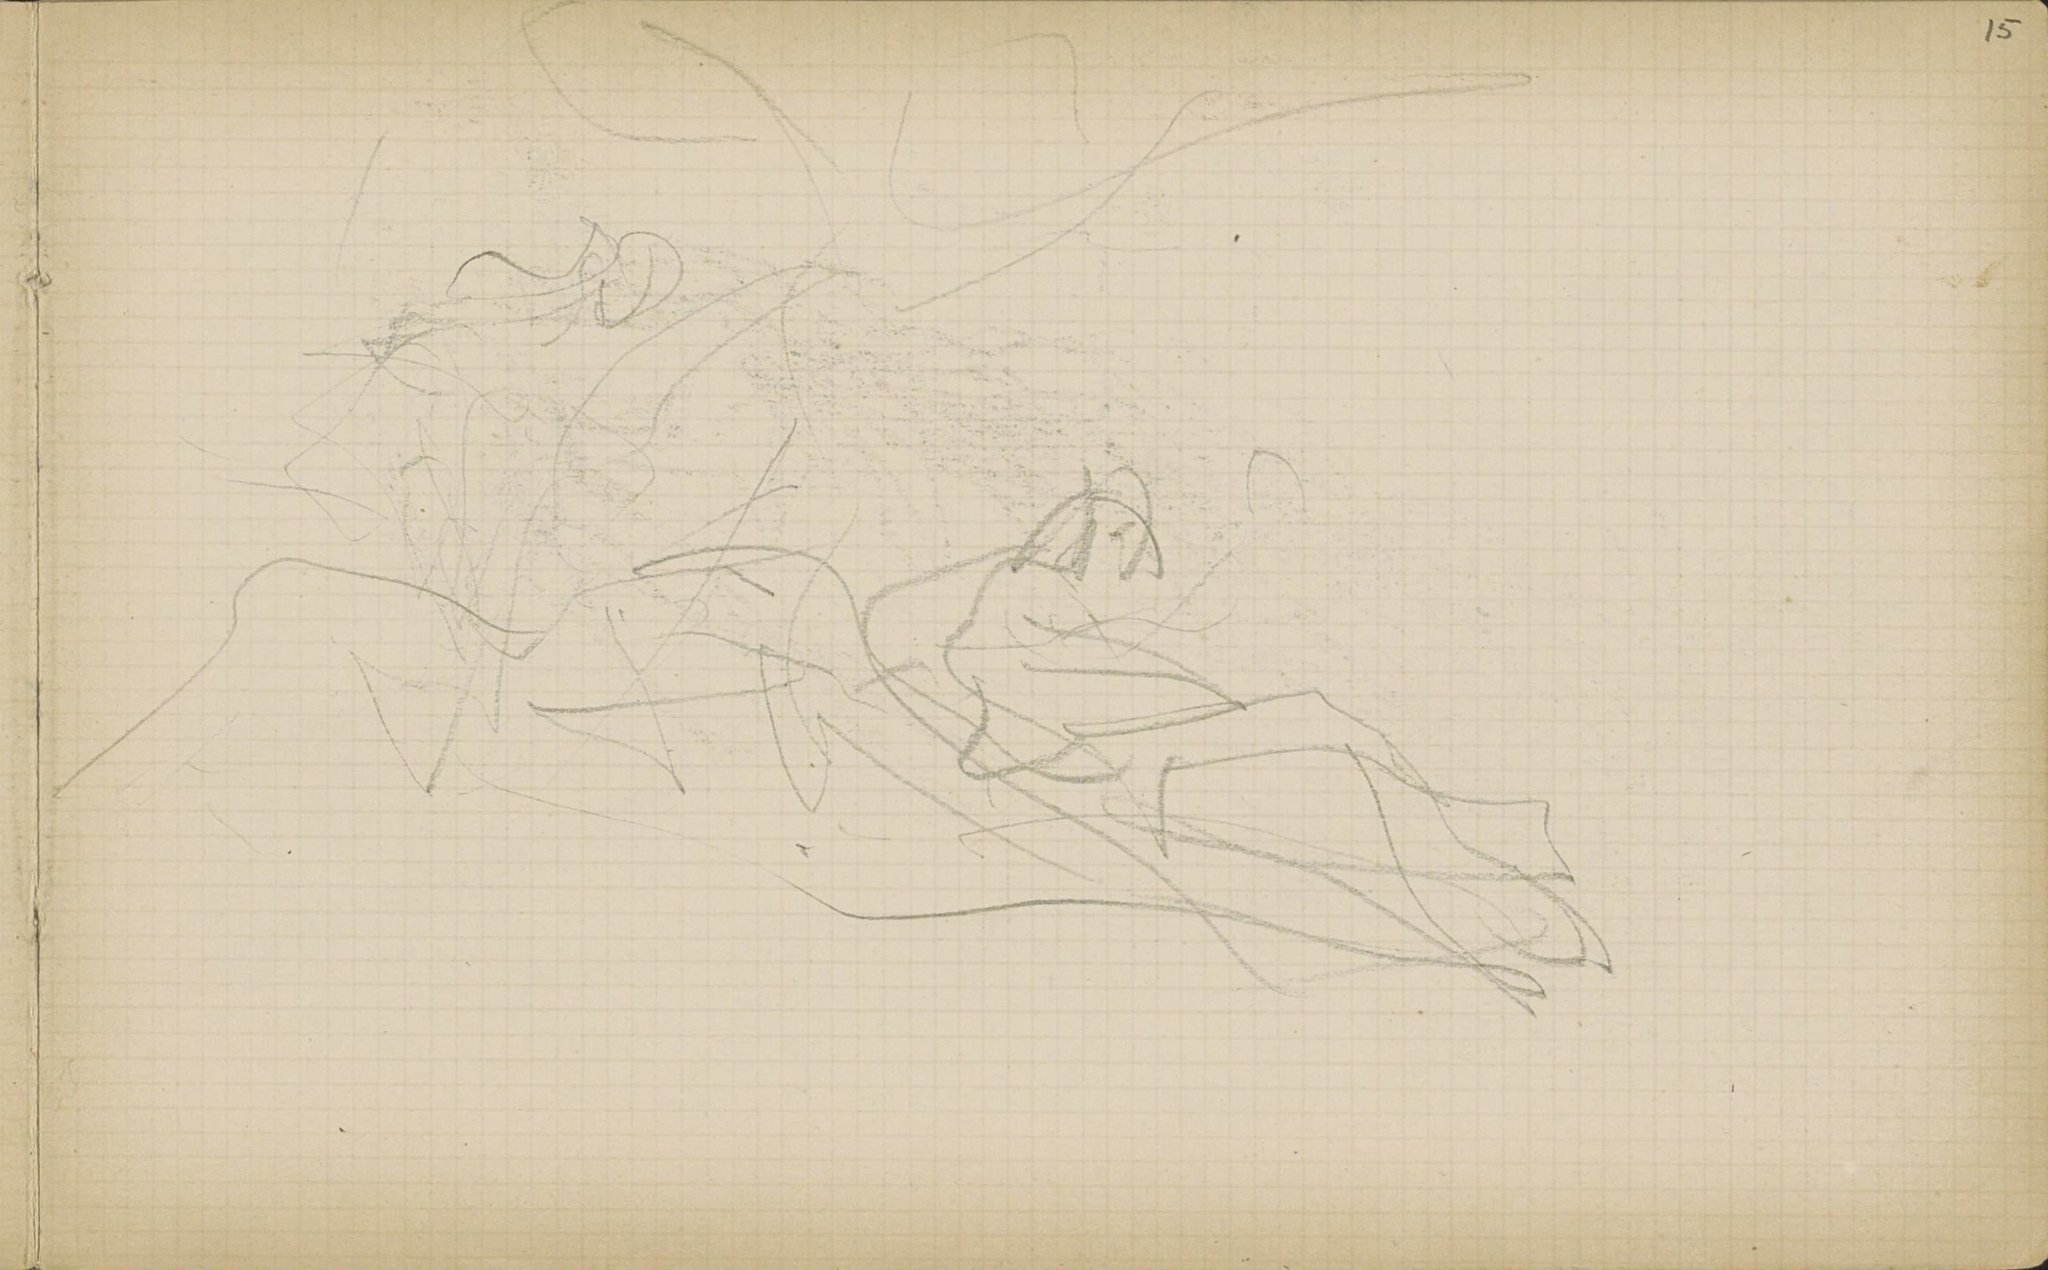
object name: sketchbook leaf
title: Studie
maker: matthijs maris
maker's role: draughtsman, painter, print maker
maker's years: 1839-1917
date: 1849-1917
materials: pencil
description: Blad 15 recto uit een schetsboek met 35 bladen.